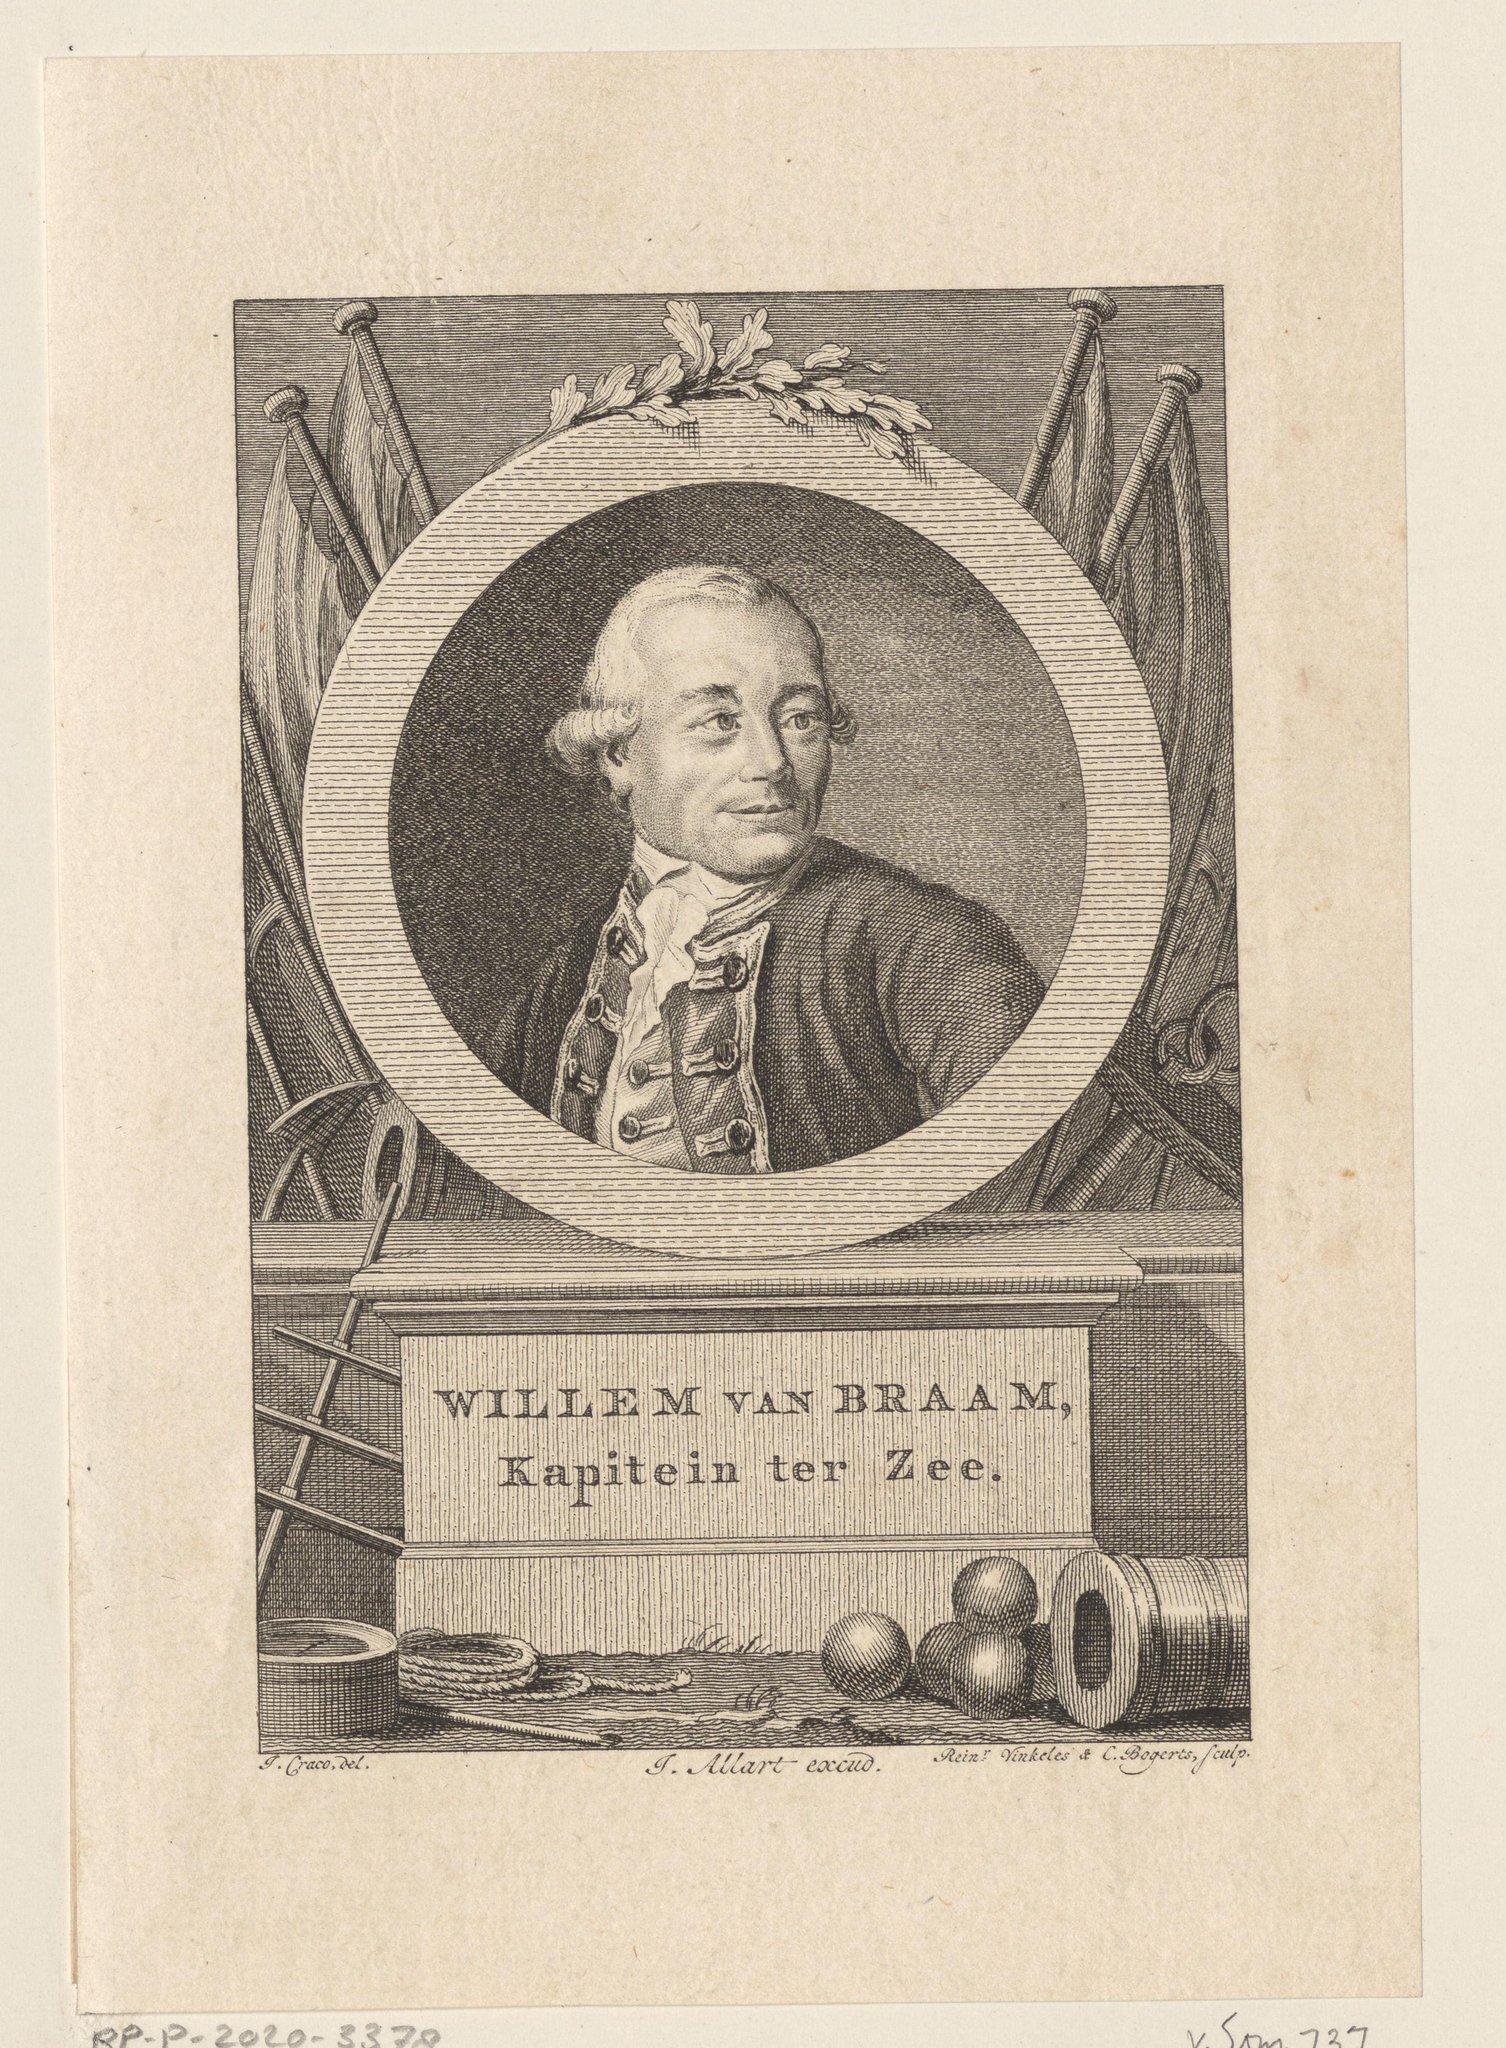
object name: print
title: Portret van Willem van Braam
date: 1773-1816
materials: paper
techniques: engraving, etching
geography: amsterdam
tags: historical persons, commander-in-chief, admiral